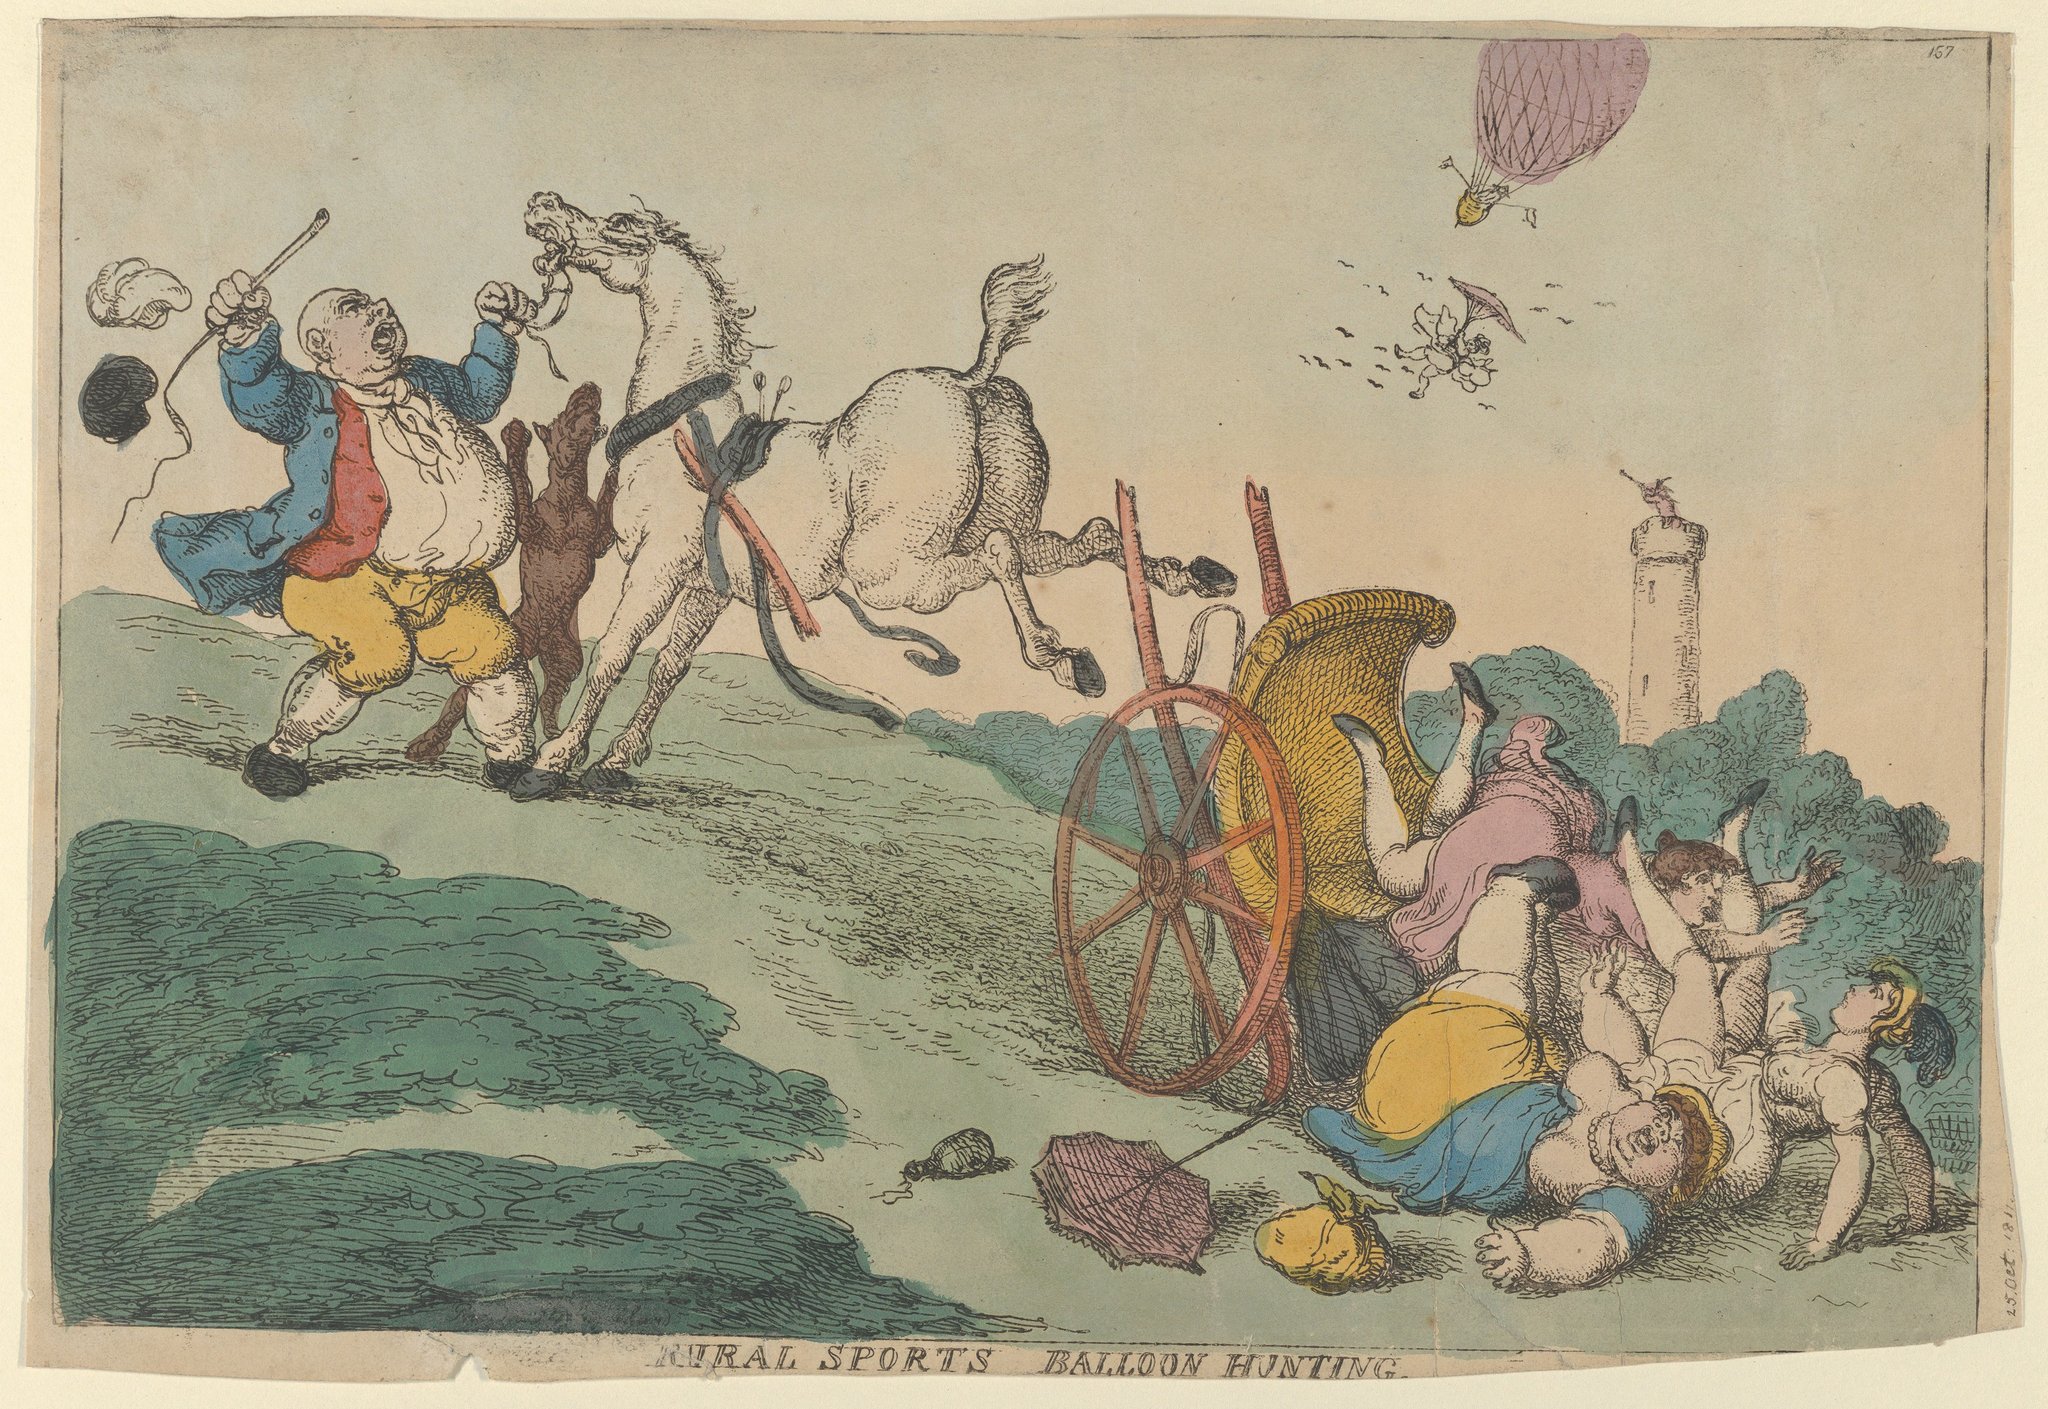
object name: print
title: Rural Sports: Balloon Hunting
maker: thomas rowlandson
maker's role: artist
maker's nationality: british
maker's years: 1757-1827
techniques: etching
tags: satire,men,women,horses,carriages,hot air balloons